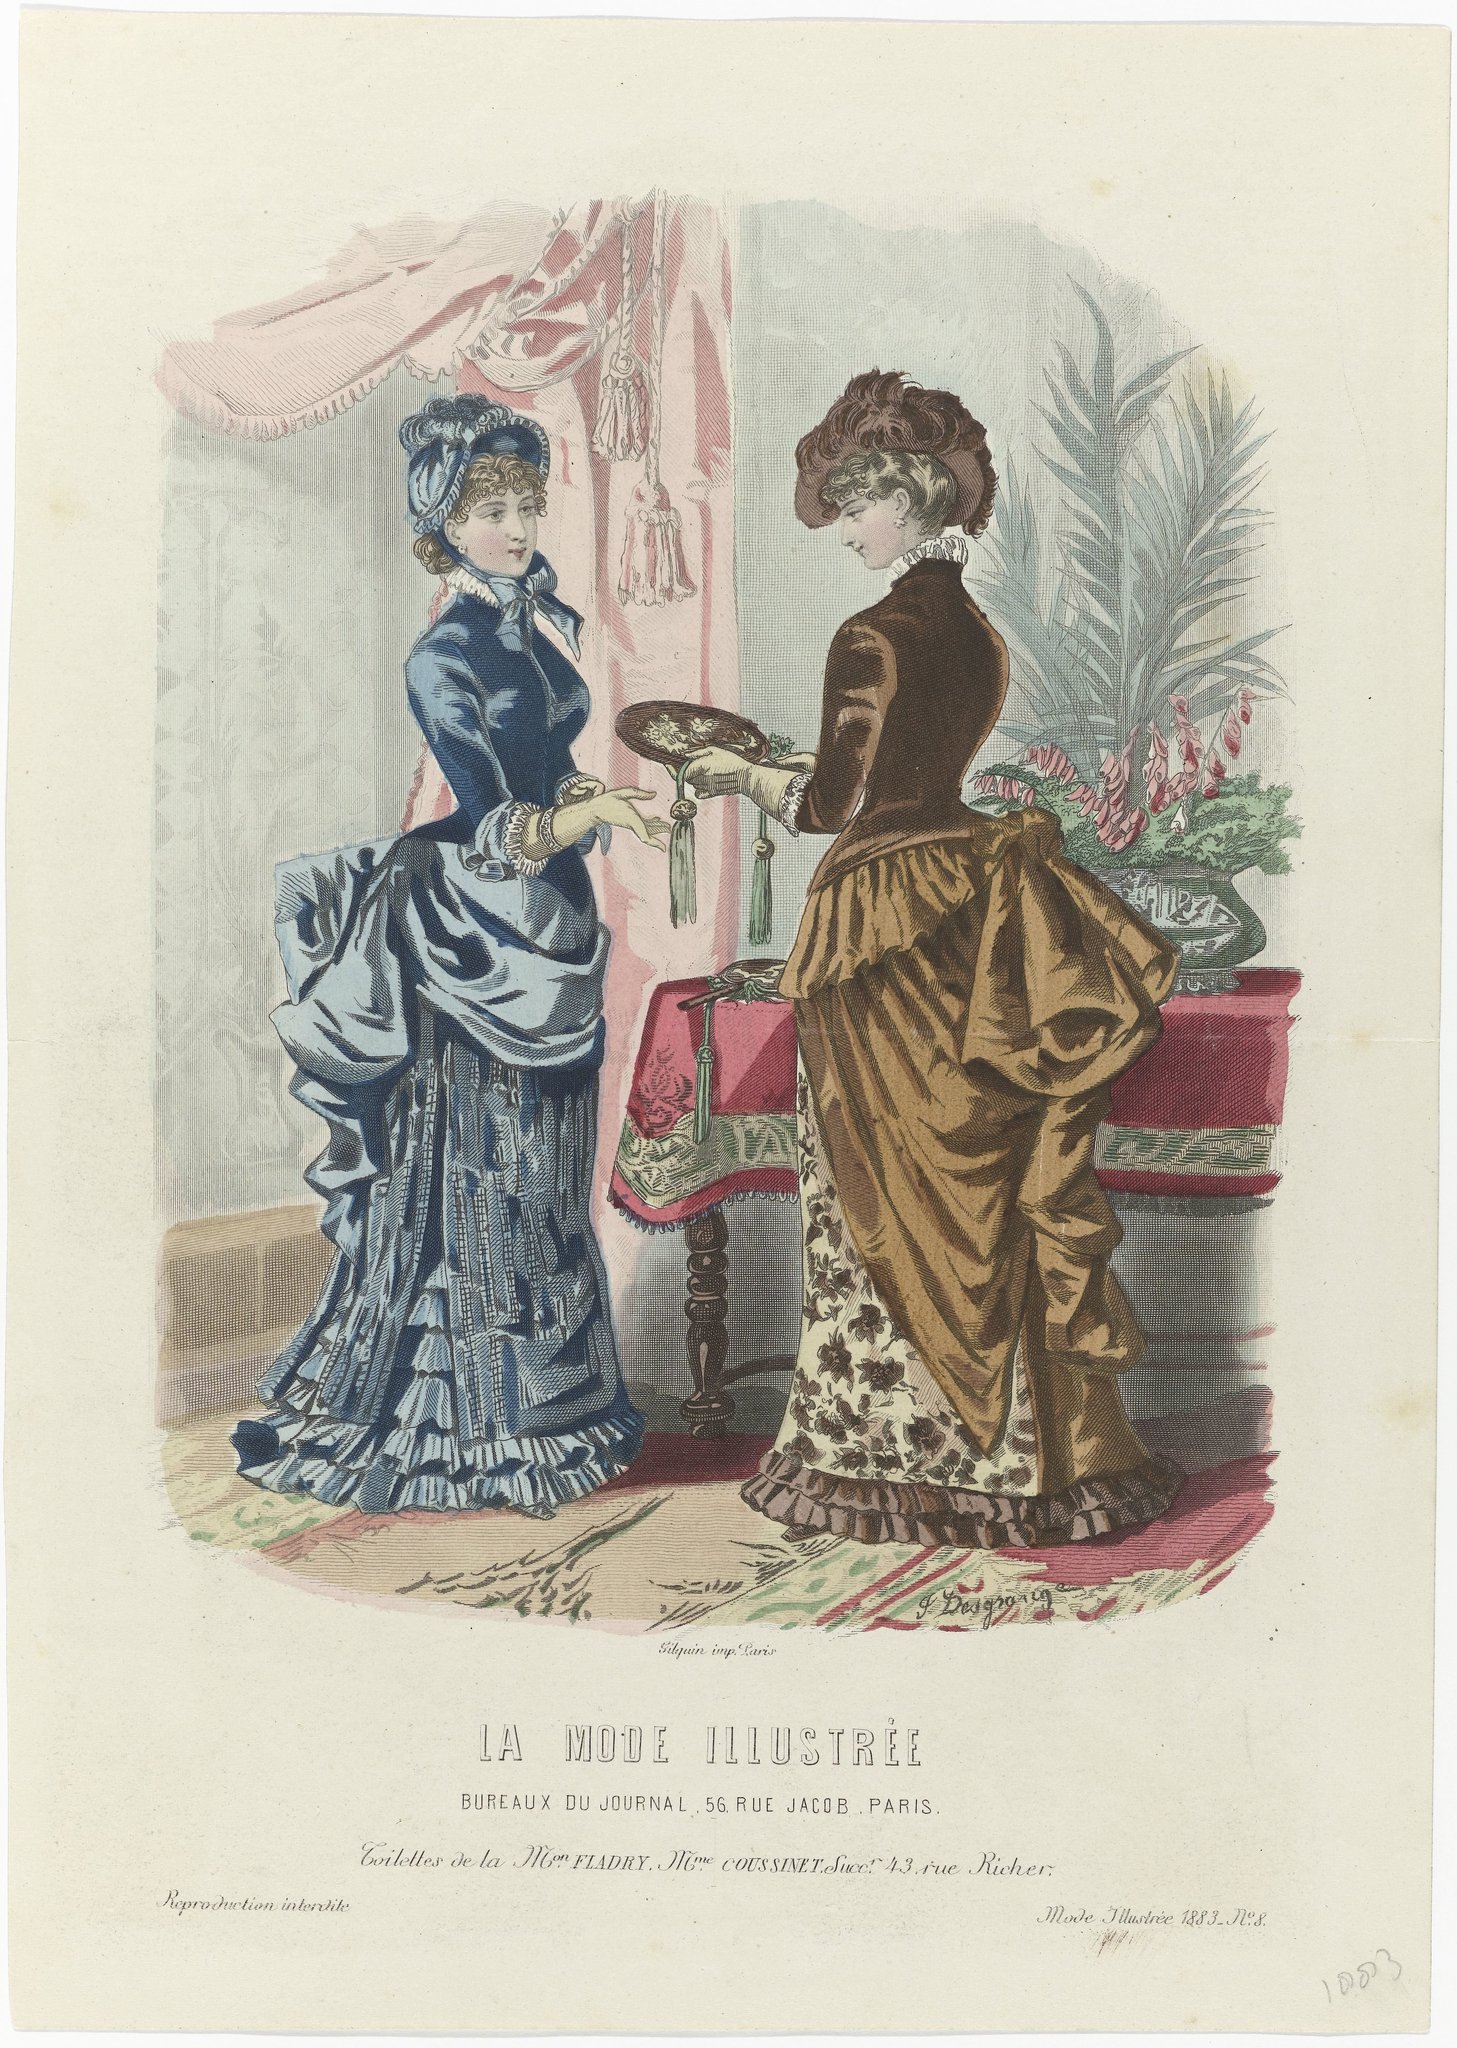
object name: fashion print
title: La Mode Illustrée, 1883, No. 8 : Toilettes de Mon. Fladry (...)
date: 1883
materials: paper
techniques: engraving, hand coloring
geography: paris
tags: fashion plates, head-gear: hat (+ women's clothes), gloves, mittens, etc. (+ women's clothes), dress, gown (+ women's clothes), bracelet, wristlet (+ women's clothes)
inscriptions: title: ‘La Mode Illustrée’, address: ‘Bureaux du journal, 56, Rue Jacob Paris’, caption: ‘Toilettes de la M.on Fladry. M.me Coussinet. Succ.r 43, rue Richer.’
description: Twee vrouwen in interieur, gekleed in japonnen met tournure. Volgens het onderschrift zijn de japonnen van Maison Fladry, opvolger van Coussinet. Prent uit het modetijdschrift La Mode Illustrée (1860-1937).